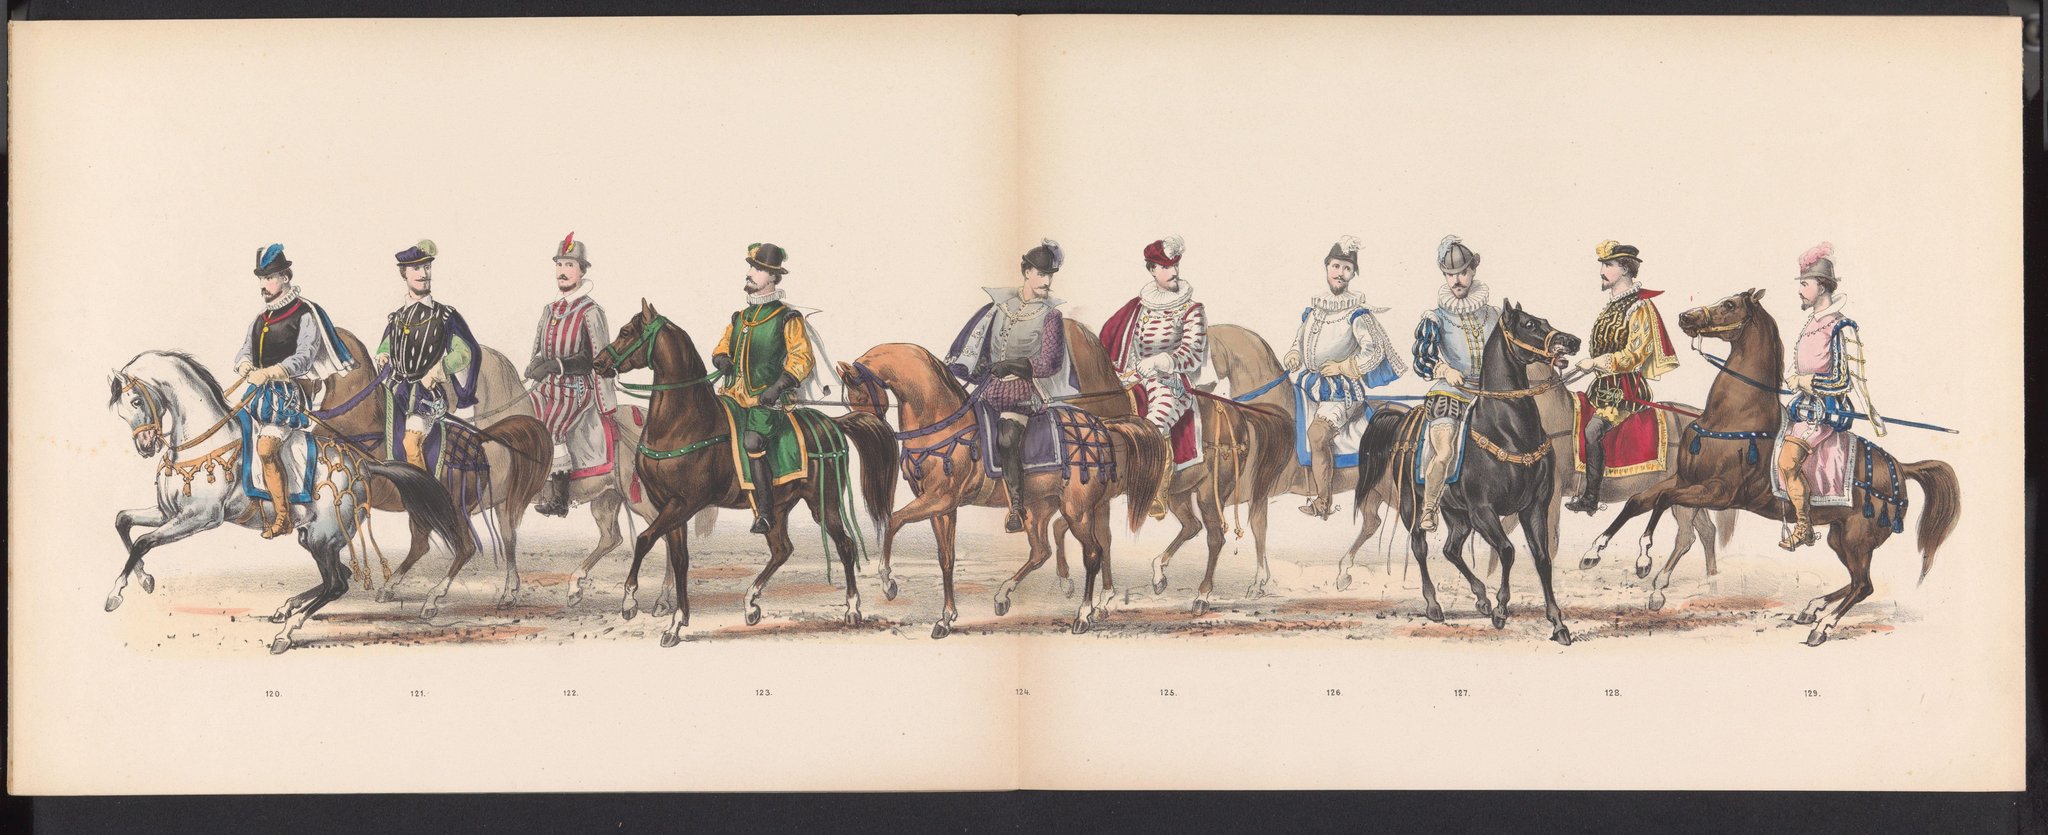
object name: print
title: Maskerade van de Leidse studenten, 1870 (plaat 10)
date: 1870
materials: paper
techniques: hand coloring, lithograph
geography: leiden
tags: robert dudley (1st earl of leicester), students' pageant, costumes used in pageants, leiden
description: Historische gekostumeerde optocht van de studenten van de Leidse Hogeschool gehouden op 7 juni 1870 ter gelegenheid van het 295-jarig bestaan van de Hogeschool. De optocht verbeeldt de intocht van de Graaf van Leicester in Leiden in 1586. Tiende plaat met de groepen genummerd 120-129. Onderdeel van de serie van 18 aaneen geplakte bladen.